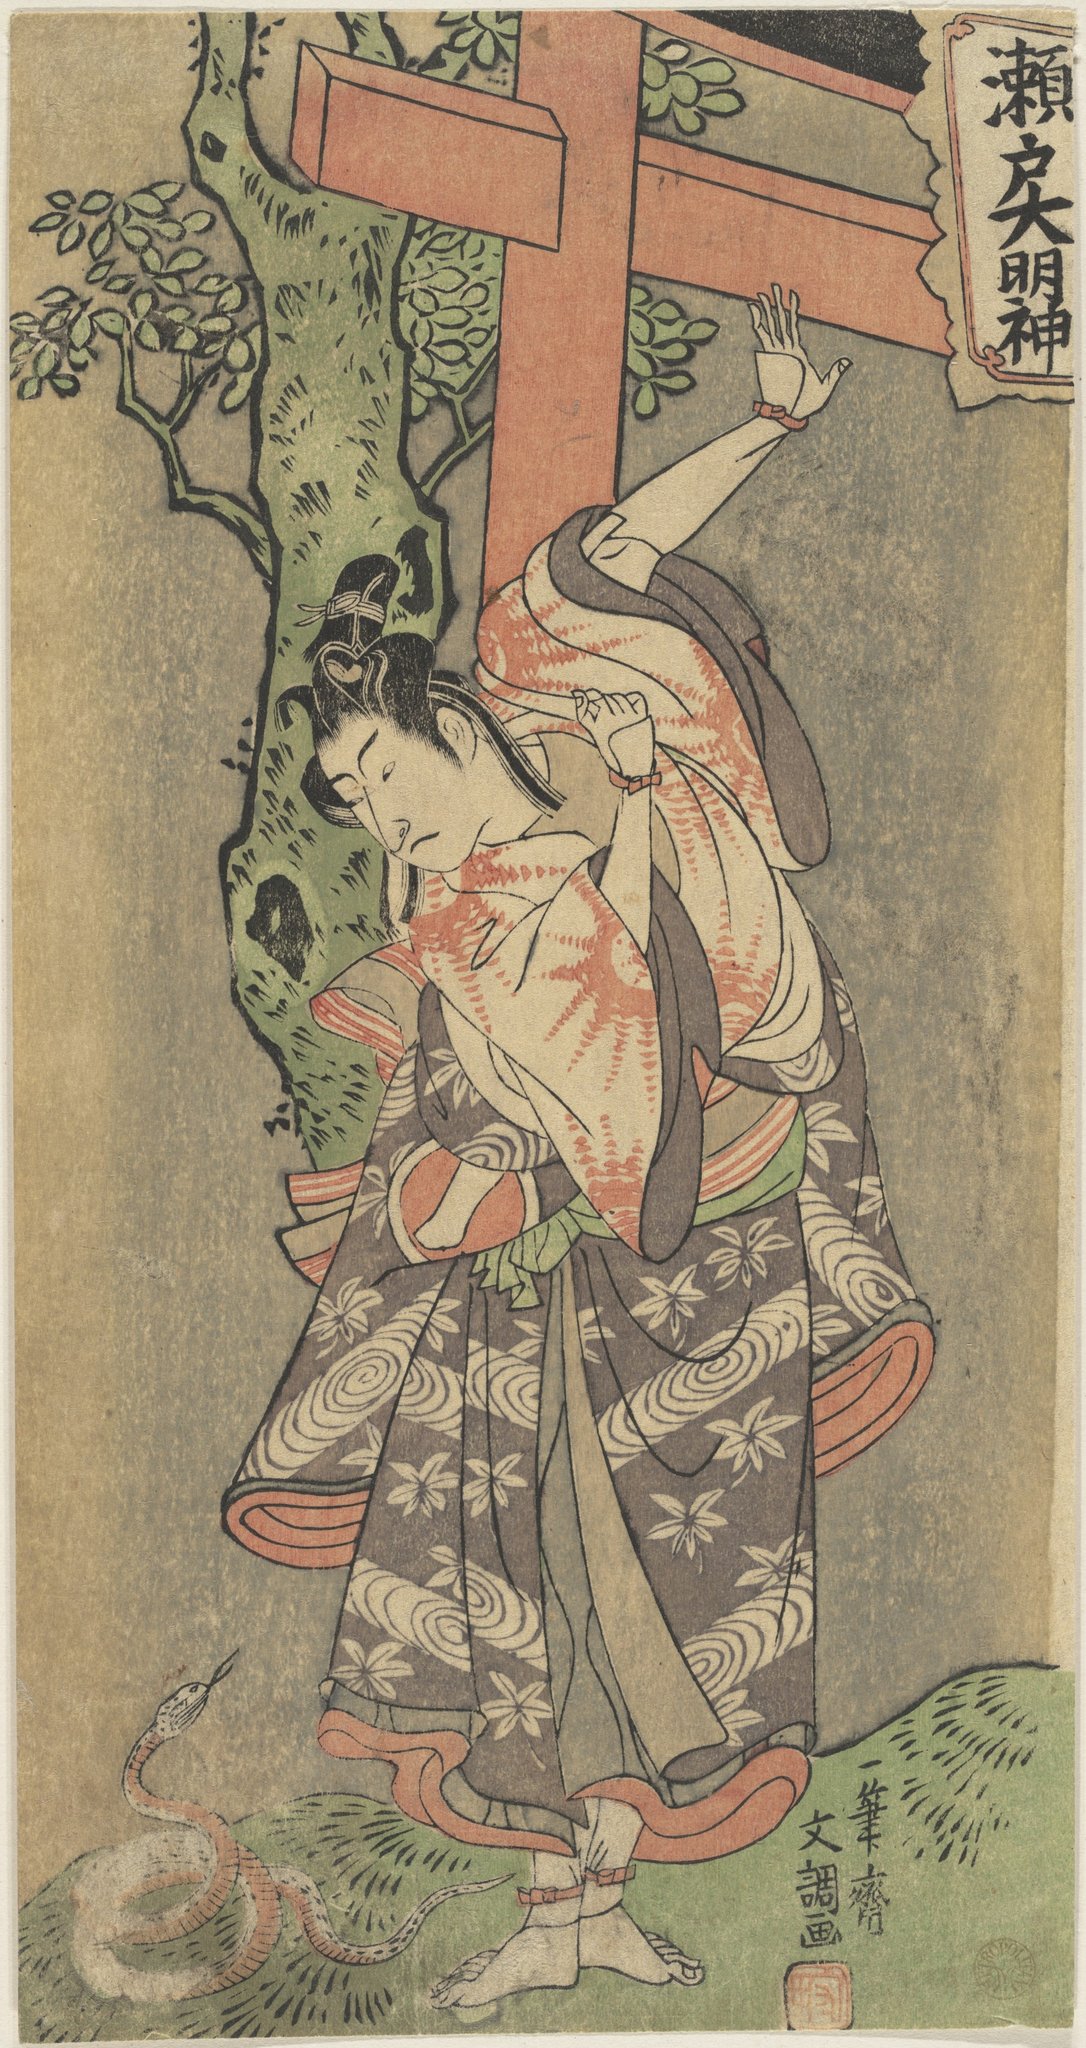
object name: print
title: Portrait of an Actor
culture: japanese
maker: ippitsusai bunchō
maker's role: artist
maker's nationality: japanese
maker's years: 1765-1792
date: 1770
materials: ink, paper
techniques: woodblock print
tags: human figures,portraits,snakes,actors